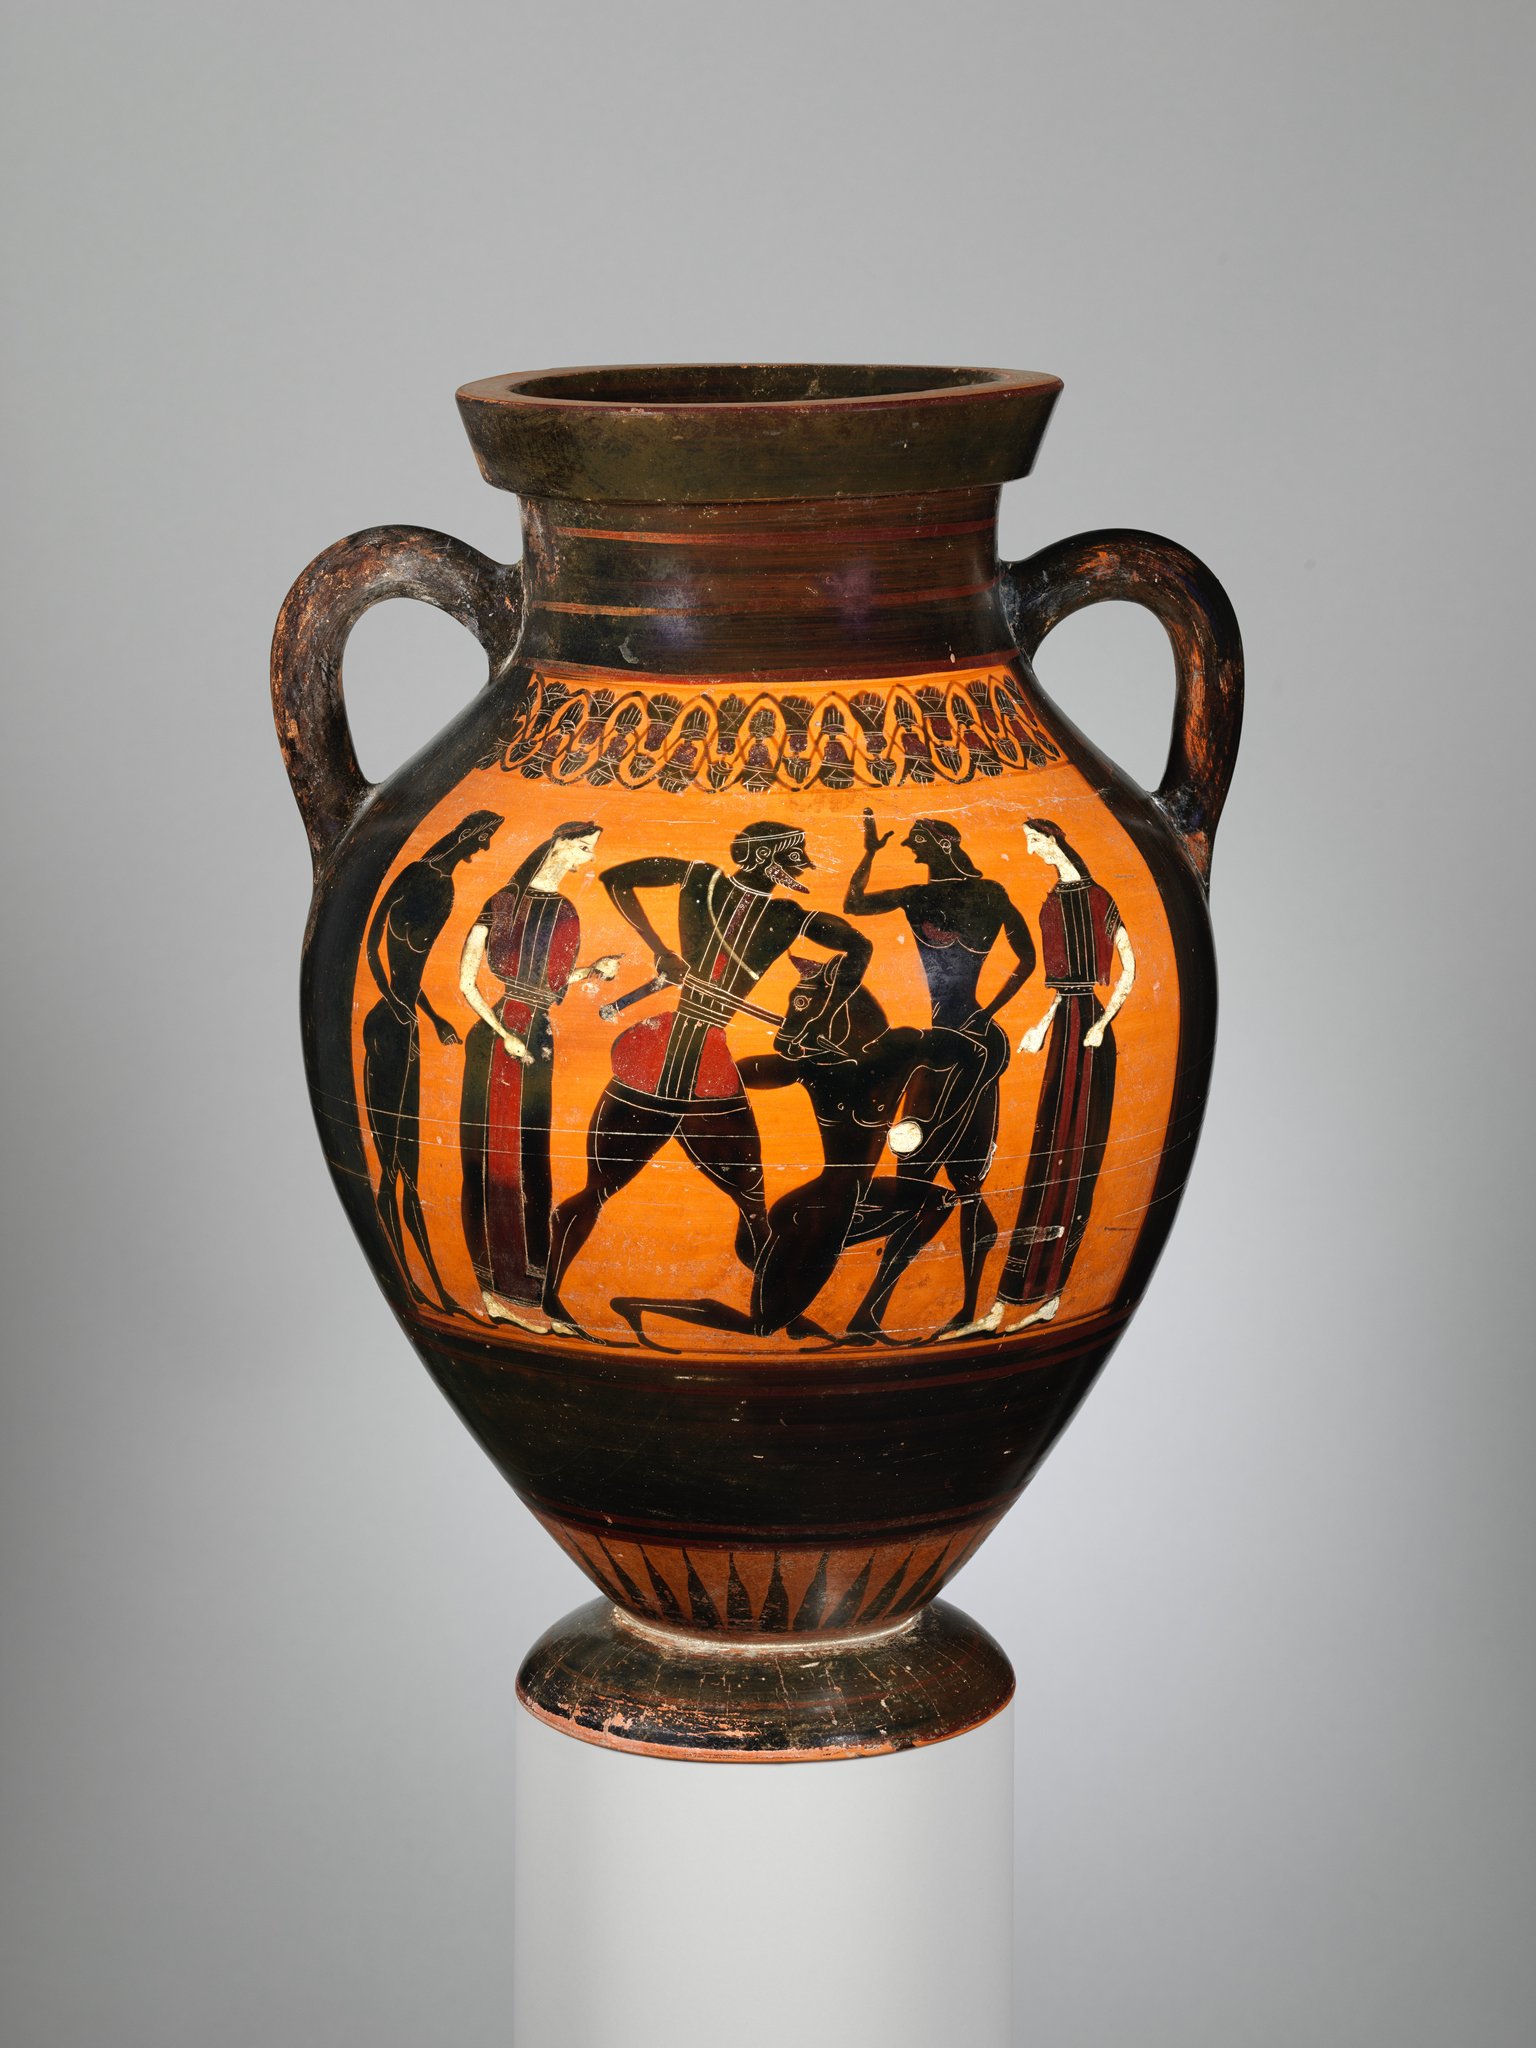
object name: amphora, type b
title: Terracotta amphora (jar)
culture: greek, attic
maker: group e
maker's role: artist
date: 540 BCE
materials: terracotta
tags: women,theseus,minotaurs